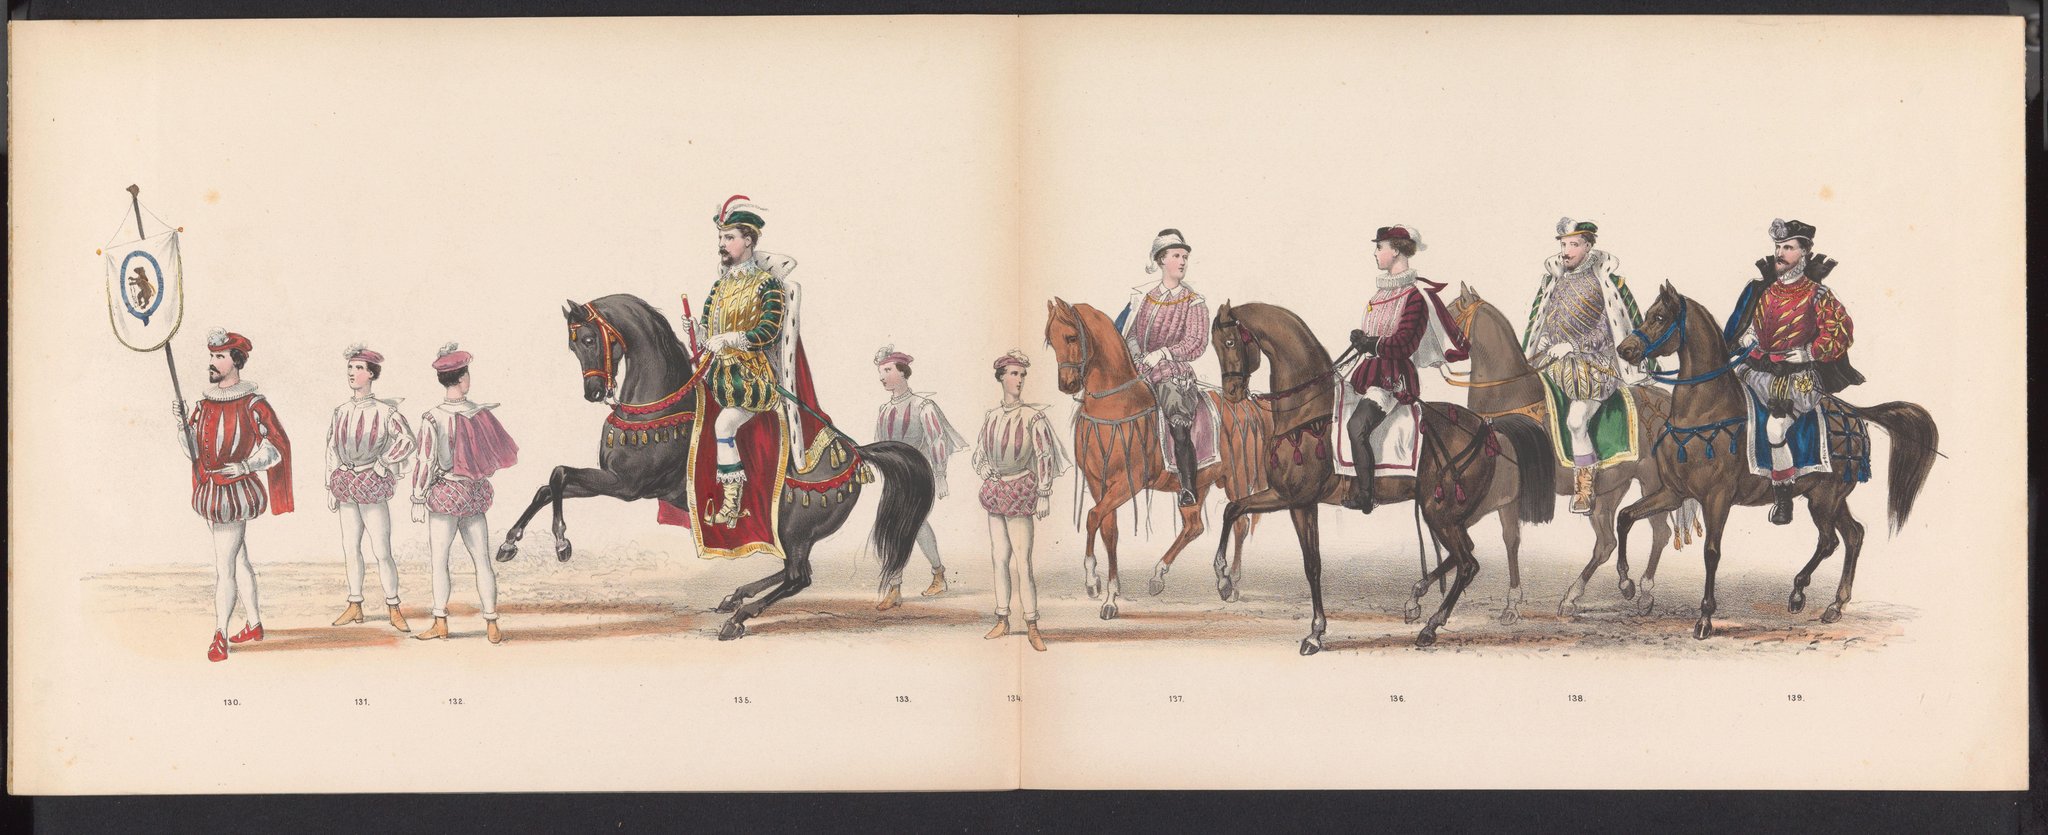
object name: print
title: Gecostumeerde optogt gehouden door de leden van het Leidsche studentencorps den 7den Junij 1870, ter viering van den 295sten verjaardag der Leidsche Hoogeschool, voorstellende bezoek gebragt aan Leiden in 1586, door Robert Lord Dudley, Baron van Denbigh, Graaf van Leicester, enz. enz.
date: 1870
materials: paper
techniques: hand coloring, lithograph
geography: netherlands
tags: robert dudley (1st earl of leicester), students' pageant, costumes used in pageants, leiden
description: Historische gekostumeerde optocht van de studenten van de Leidse Hogeschool gehouden op 7 juni 1870 ter gelegenheid van het 295-jarig bestaan van de Hogeschool. De optocht verbeeldt de intocht van de Graaf van Leicester in Leiden in 1586. Elfde plaat met de groepen genummerd 130-139. Onderdeel van de serie van 18 aaneen geplakte bladen.